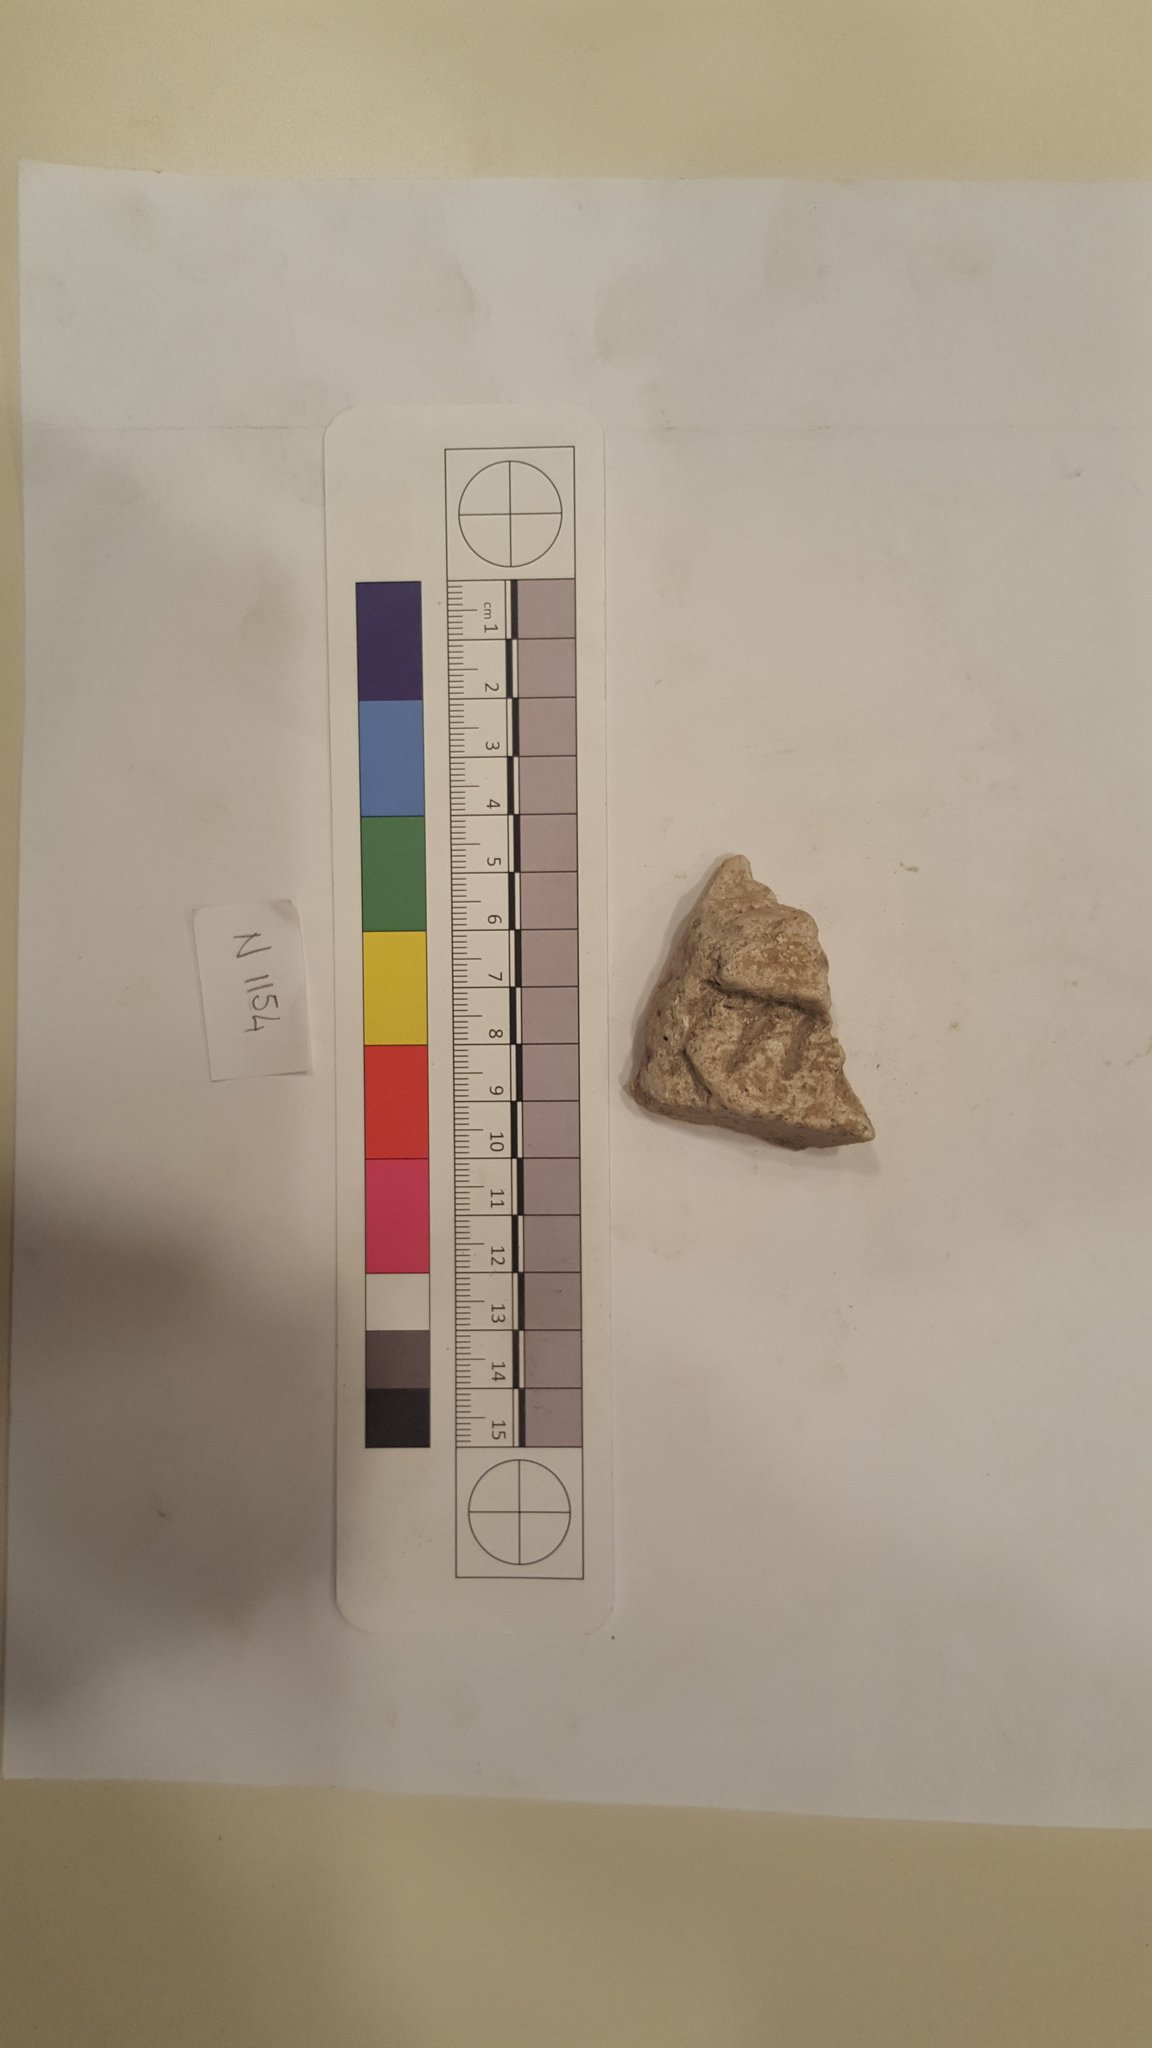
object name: fragment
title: Stucco Fragment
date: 701-1200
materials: plaster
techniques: carving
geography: iran